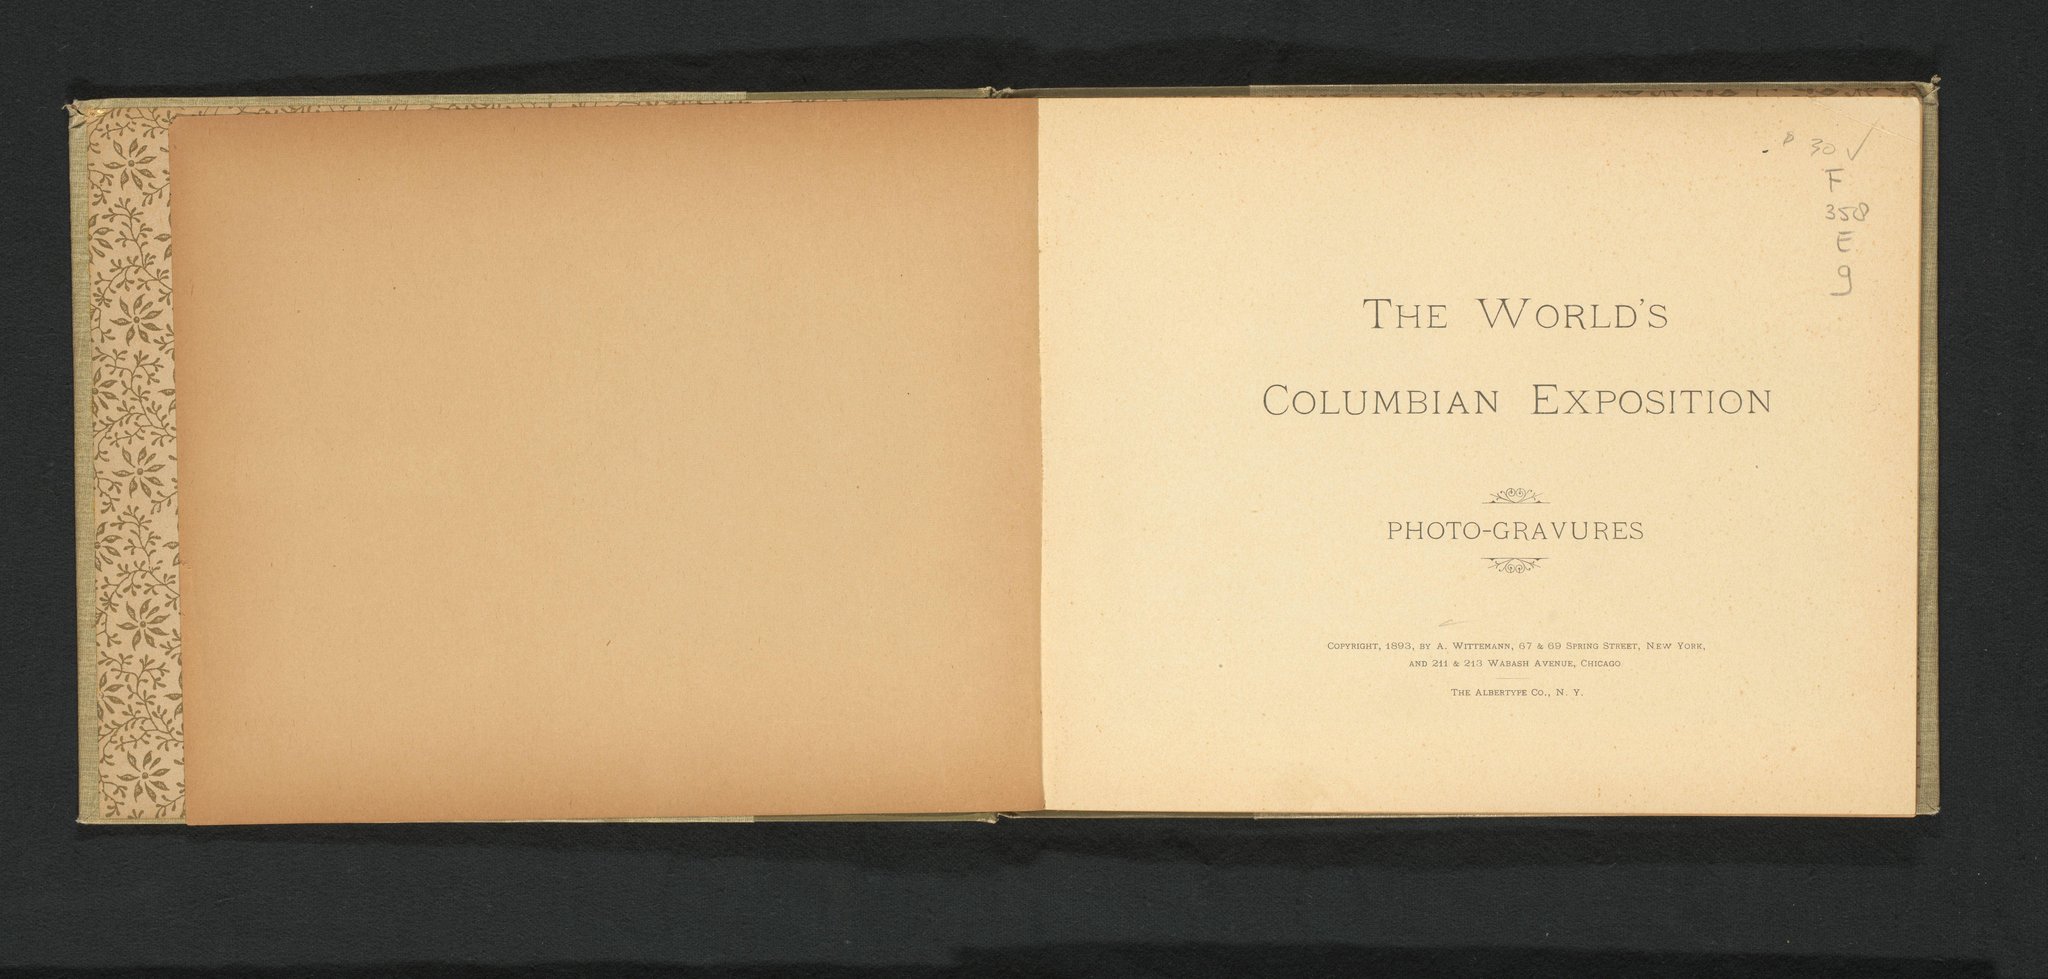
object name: book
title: The world's Columbian exposition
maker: adolph wittemann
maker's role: publisher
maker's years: 1845-1938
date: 1893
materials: cardboard, linen, paper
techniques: photograph, decorated paper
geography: new york city